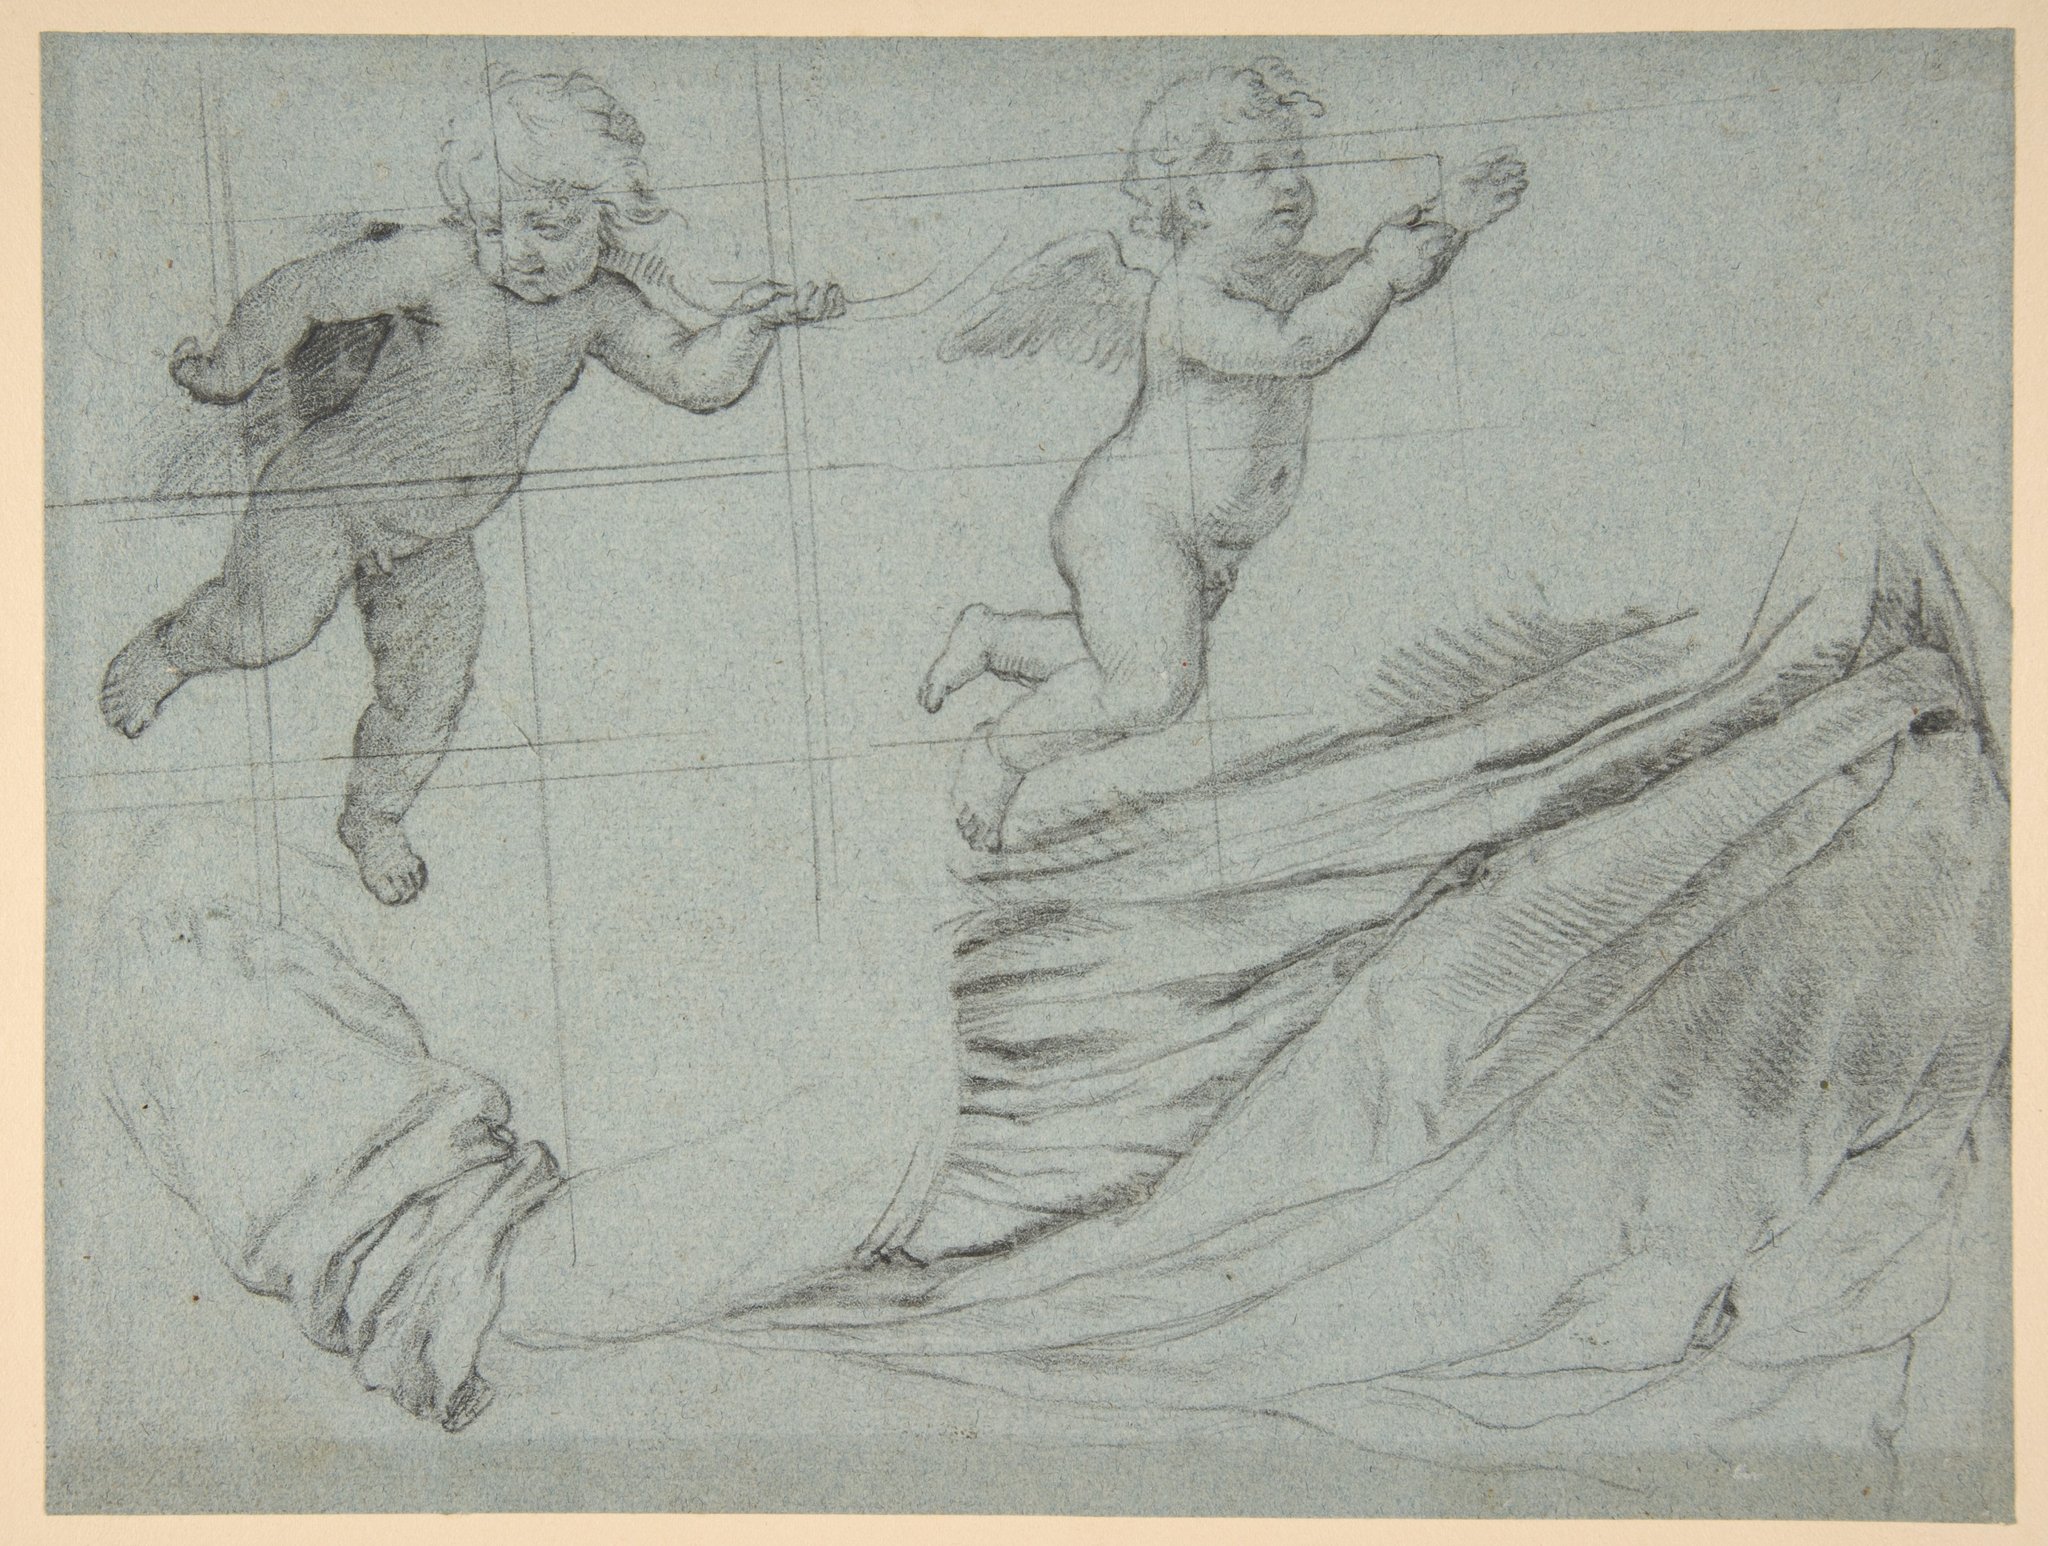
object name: drawing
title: Studies of Two Flying Putti and of Drapery (recto); Seated Virgin and Child, and Kneeling Child (verso)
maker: sassoferrato (giovanni battista salvi)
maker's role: artist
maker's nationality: italian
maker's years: 1609-1685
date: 1609-1685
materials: chalk, paper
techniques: drawing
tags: putti,madonna and child